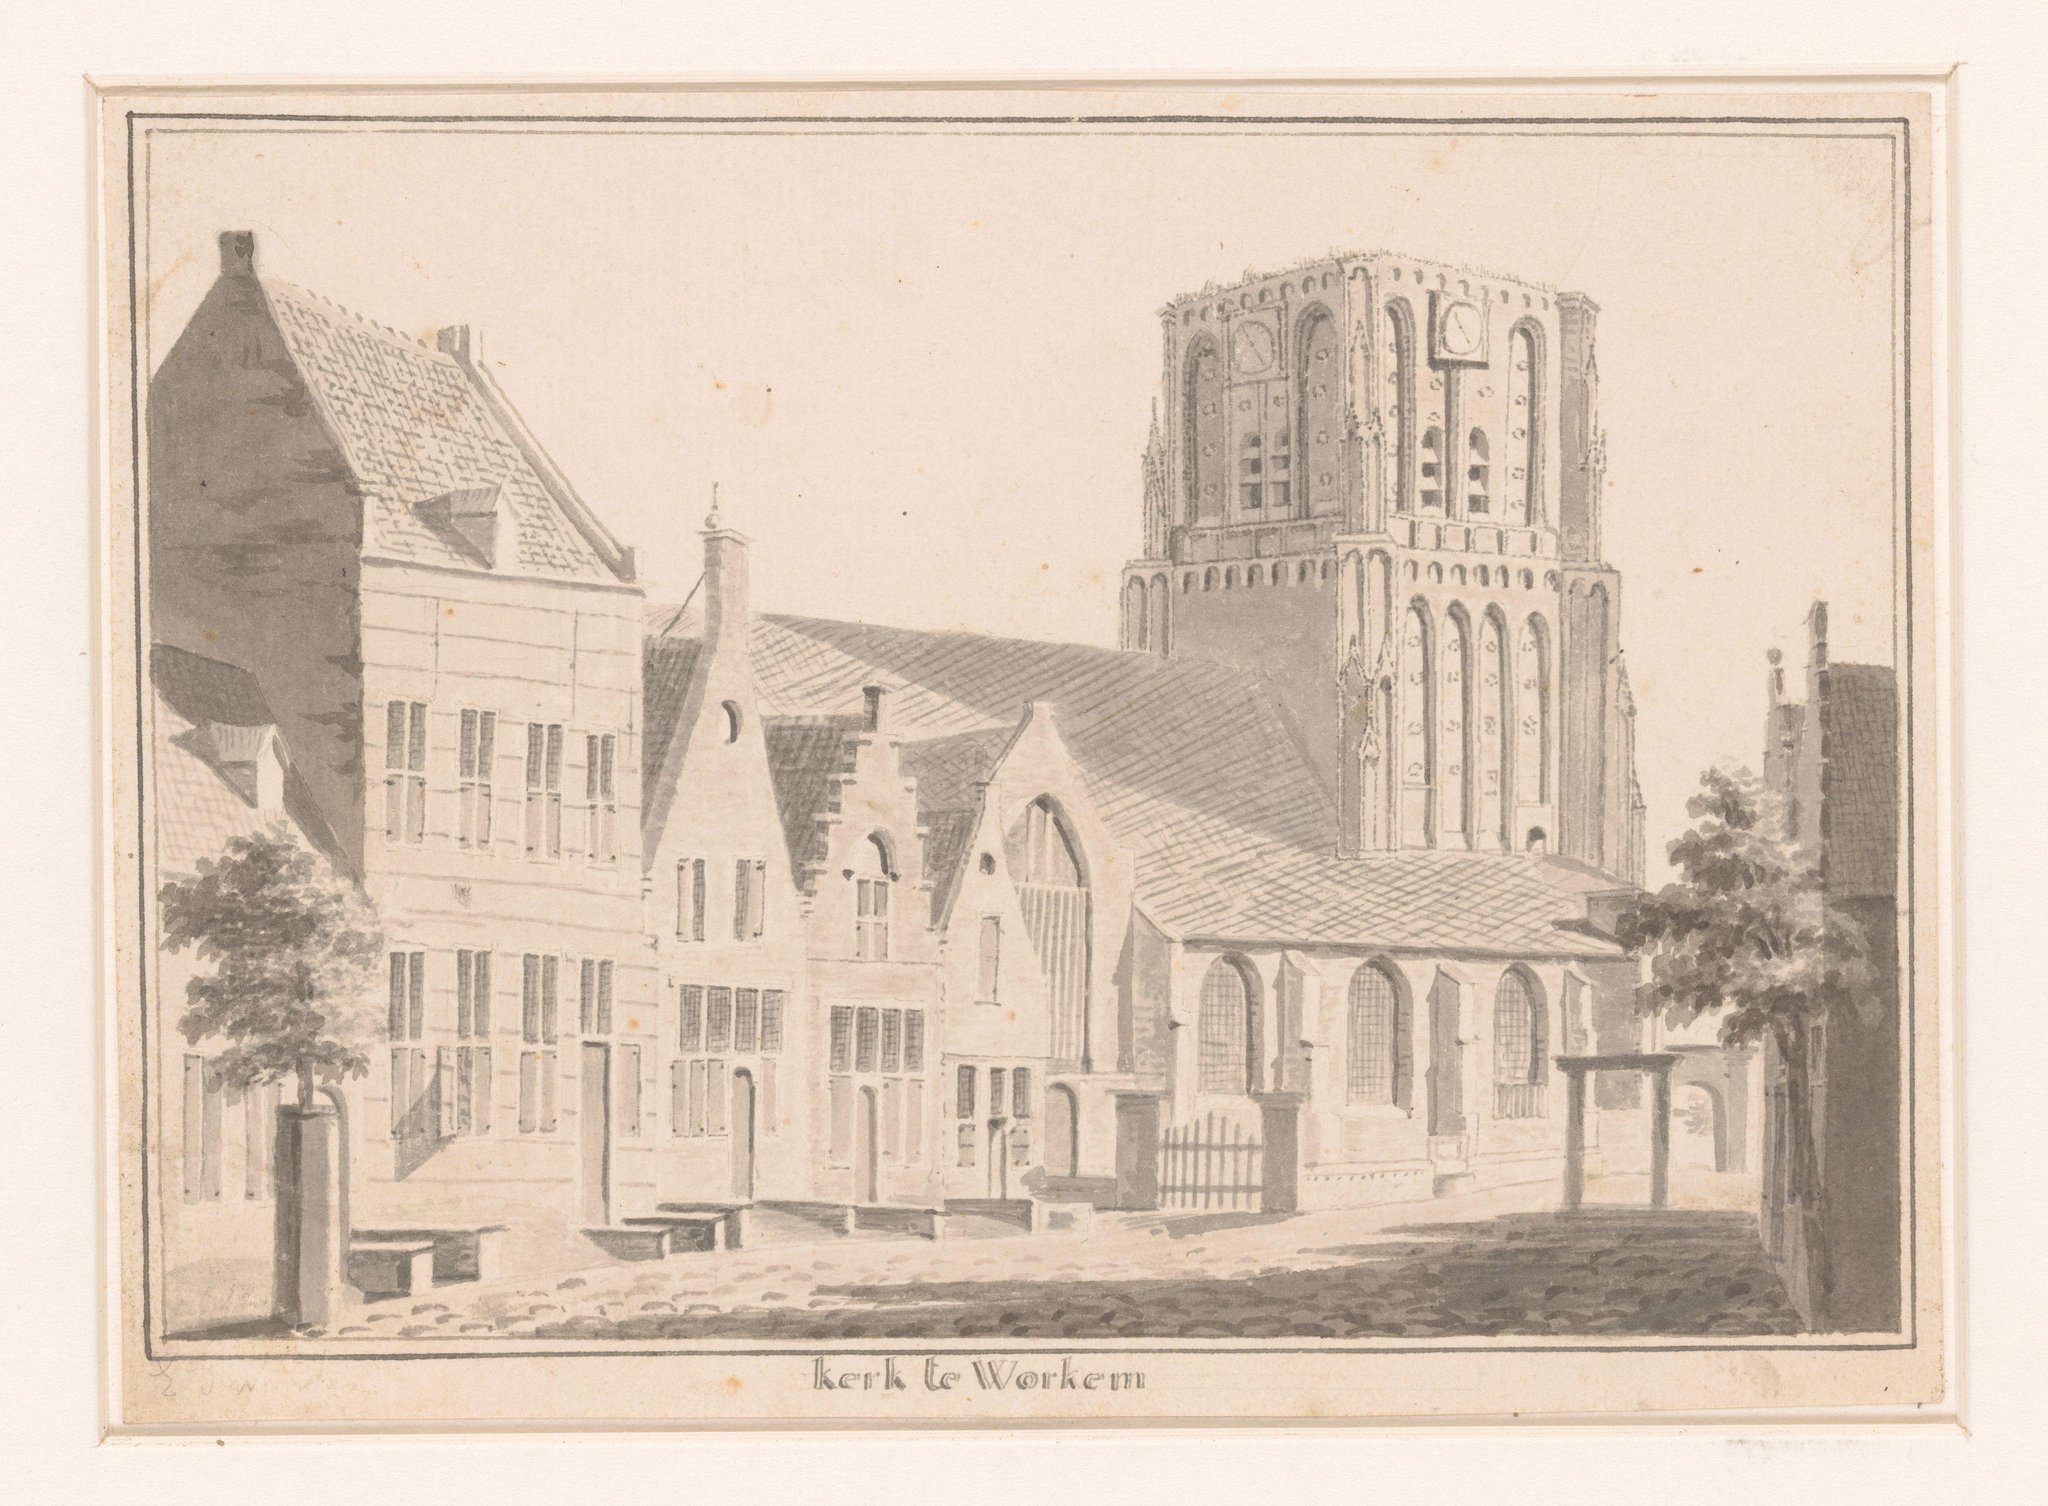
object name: drawing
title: Gezicht in Woudrichem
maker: cornelis pronk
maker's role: draughtsman, painter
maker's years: 1691-1759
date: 1732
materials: ink, paper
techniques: drawing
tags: church (exterior), prospect of city, town panorama, silhouette of city, woudrichem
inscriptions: collector's mark: Lugt 2228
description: Ontwerp voor de prent in: Verheerlykt Nederland, of, kabinet van hedendaagsche gezigten (...). 3 dln. Amsterdam: Isaak Tirion, 1745, dl. 3, nr. 233.